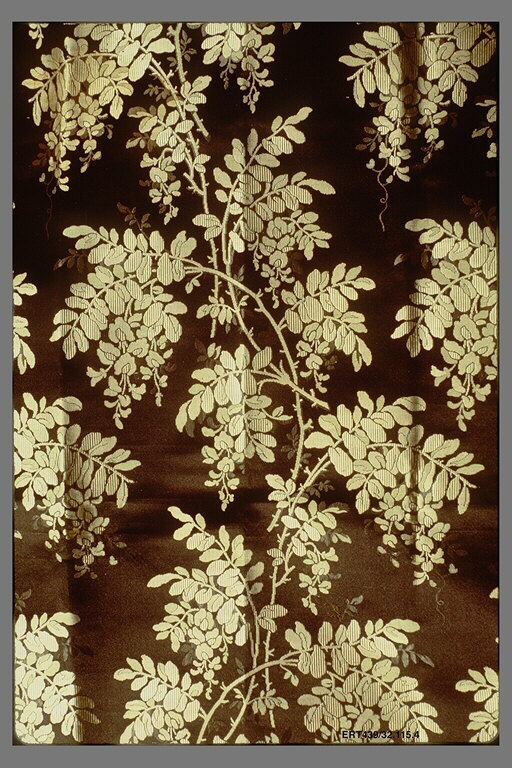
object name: piece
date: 1858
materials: silk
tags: leaves